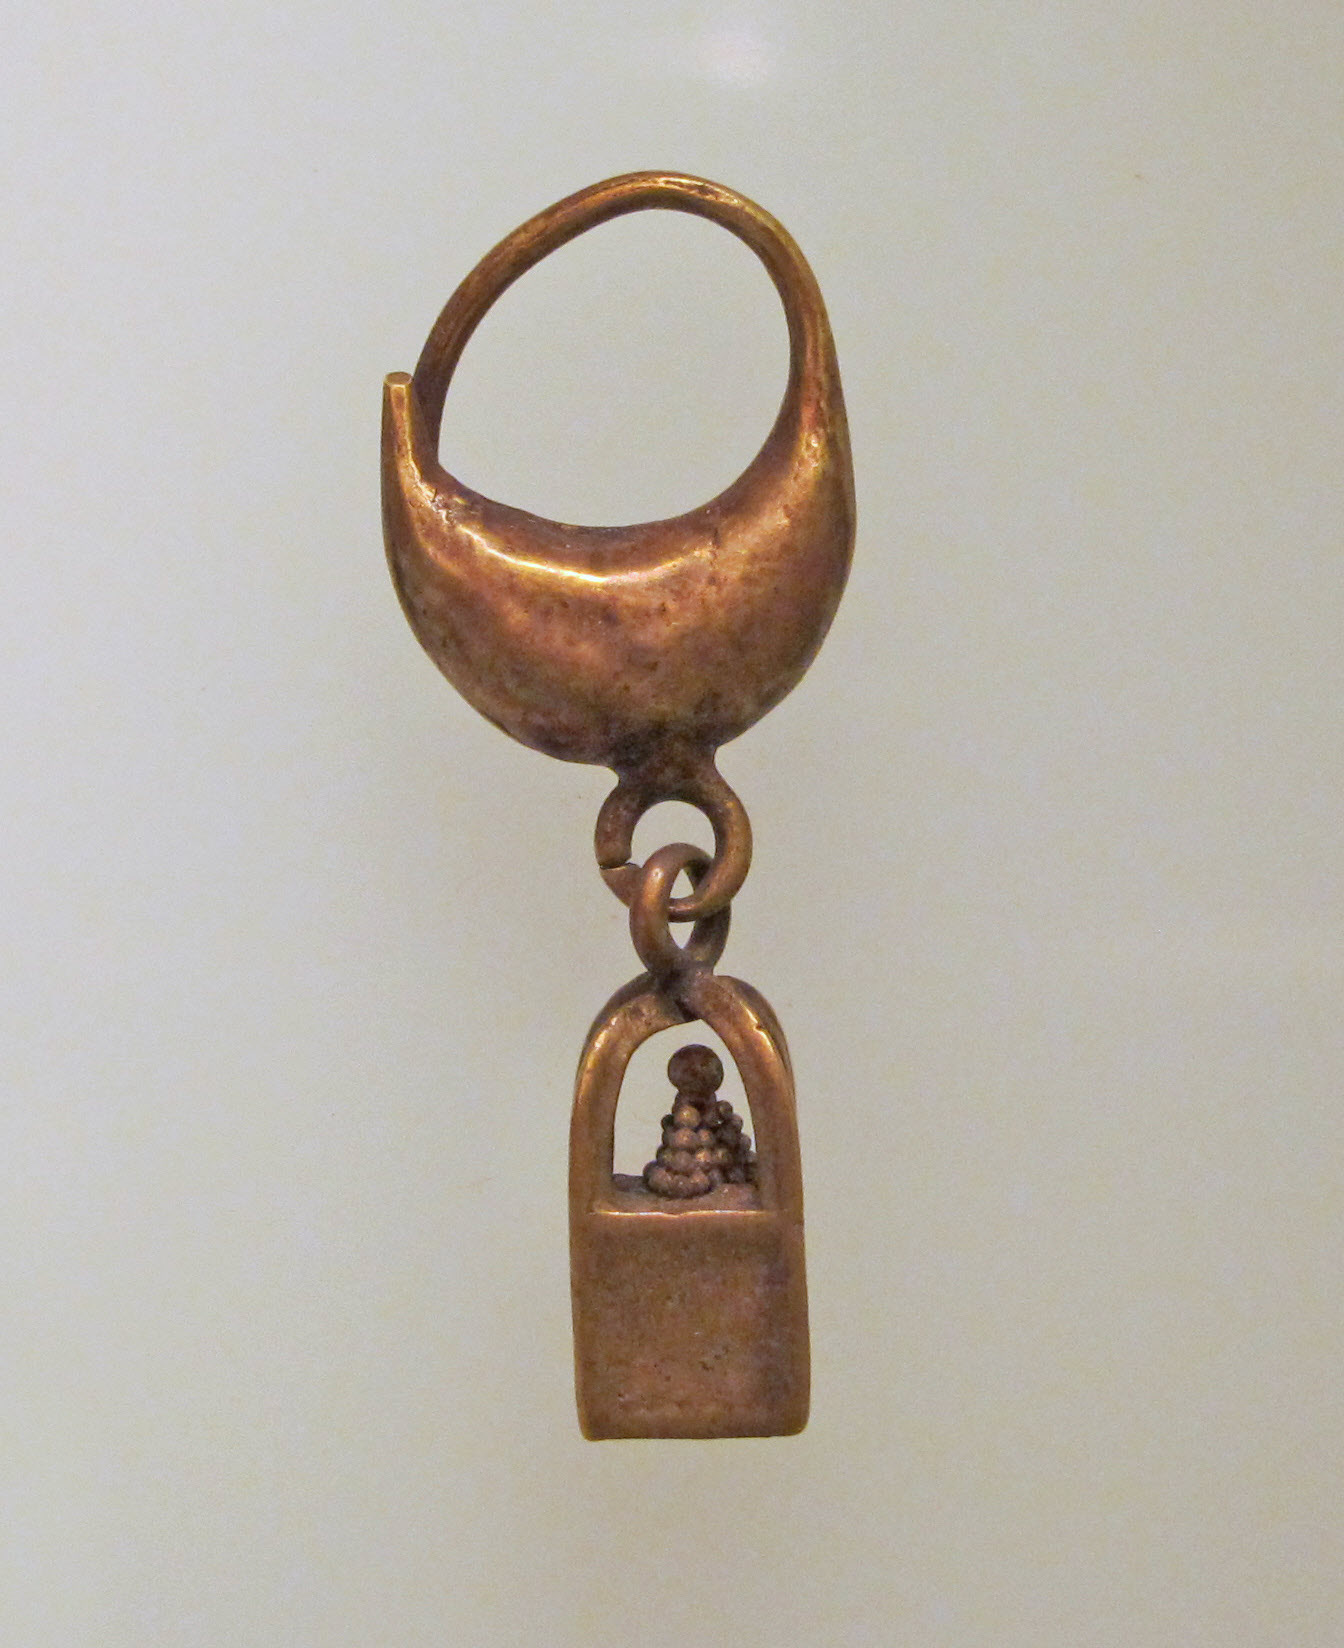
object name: earring with leech and box pendant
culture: cypriot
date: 700-501 BCE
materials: gold